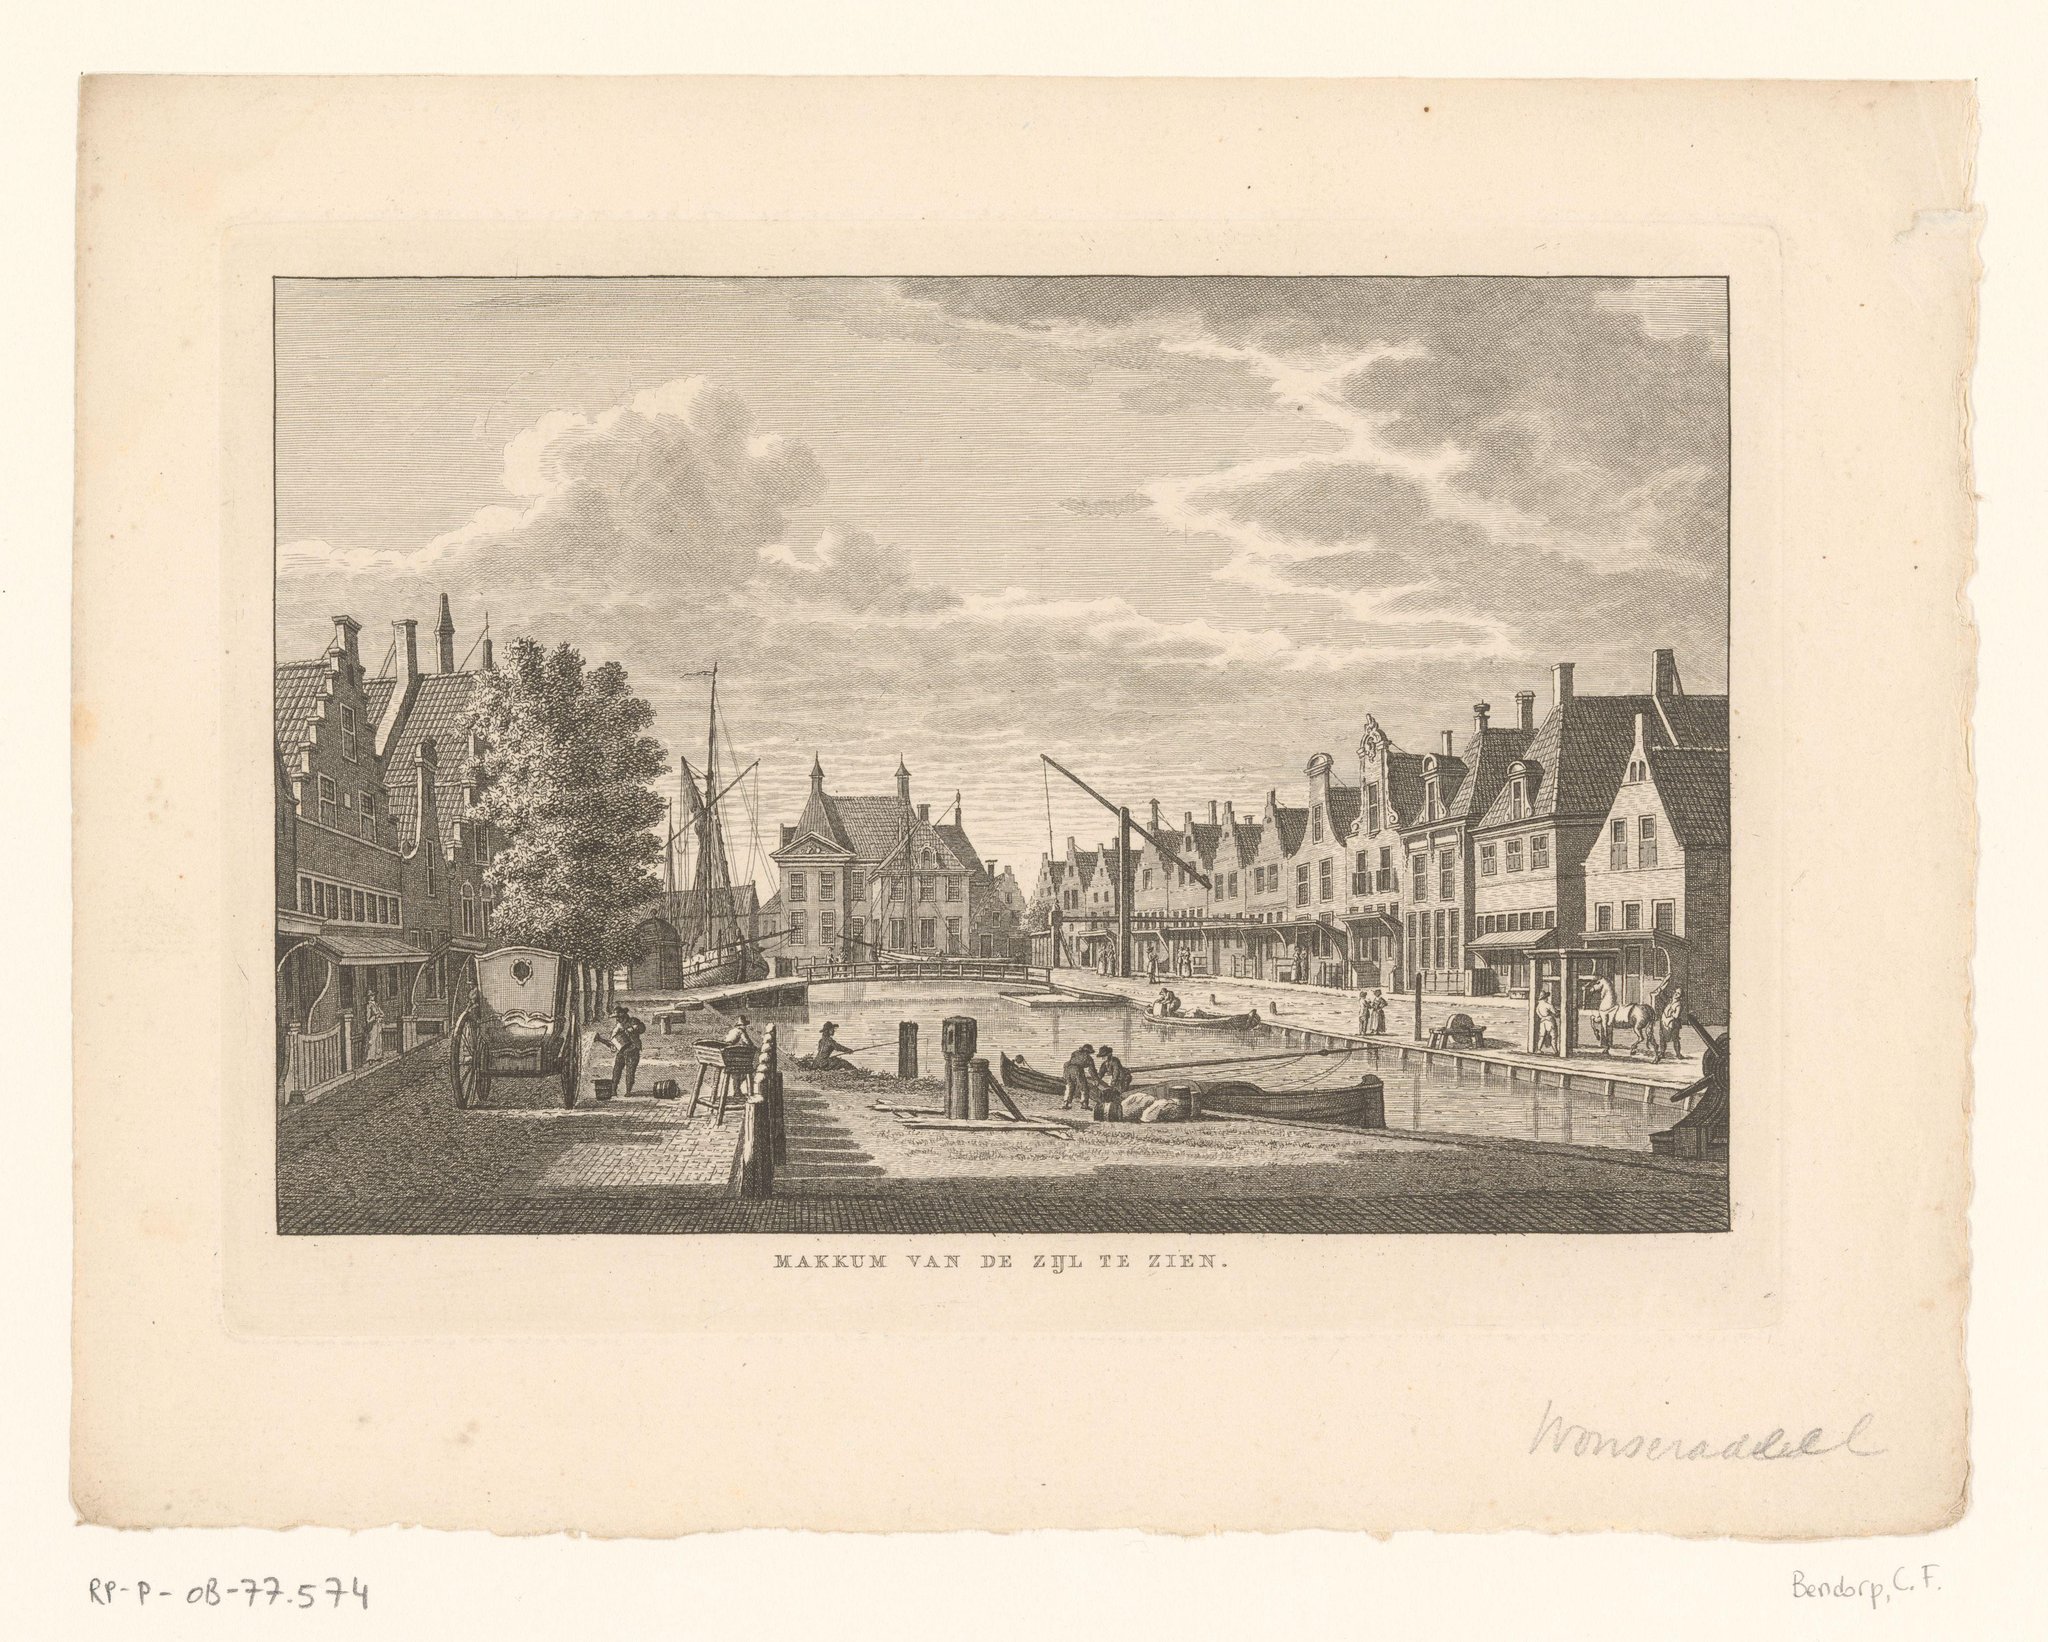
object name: print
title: Gezicht op Makkum vanaf de Grote Zijlroede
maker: carel frederik bendorp (i)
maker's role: print maker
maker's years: 1736-1814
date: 1786-1792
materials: paper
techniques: etching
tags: bridge in village across river, canal, etc., canals, waters (in village) (+ city(-scape) with figures, staffage)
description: Prent waarschijnlijk uit: Vaderlandsche gezichten, of afbeeldingen van den tegenwoordigen staat der Vereenigde Nederlanden (…). Amsterdam: Hendrik Gartman, Willem Vermandel en Jan Willem Smit, 1786-1792. Uitgegeven in afleveringen met ieder een eigen bifolium en inhoudsopgave. Alle prenten in deze publicatie zijn gegraveerd door Carel Frederik Bendorp (I) en, in de meeste gevallen, gebaseerd op tekeningen van Jan Bulthuis. Latere staat waarschijnlijk uitgegeven door Maaskamp als onderdeel van een plaatwerk uit ca. 1824-1825 met 74 (ongenummerde) platen van de belangrijkste topografische gezichten en verschillende zeden en gewoonten in het Verenigd Koninkrijk der Nederlanden.